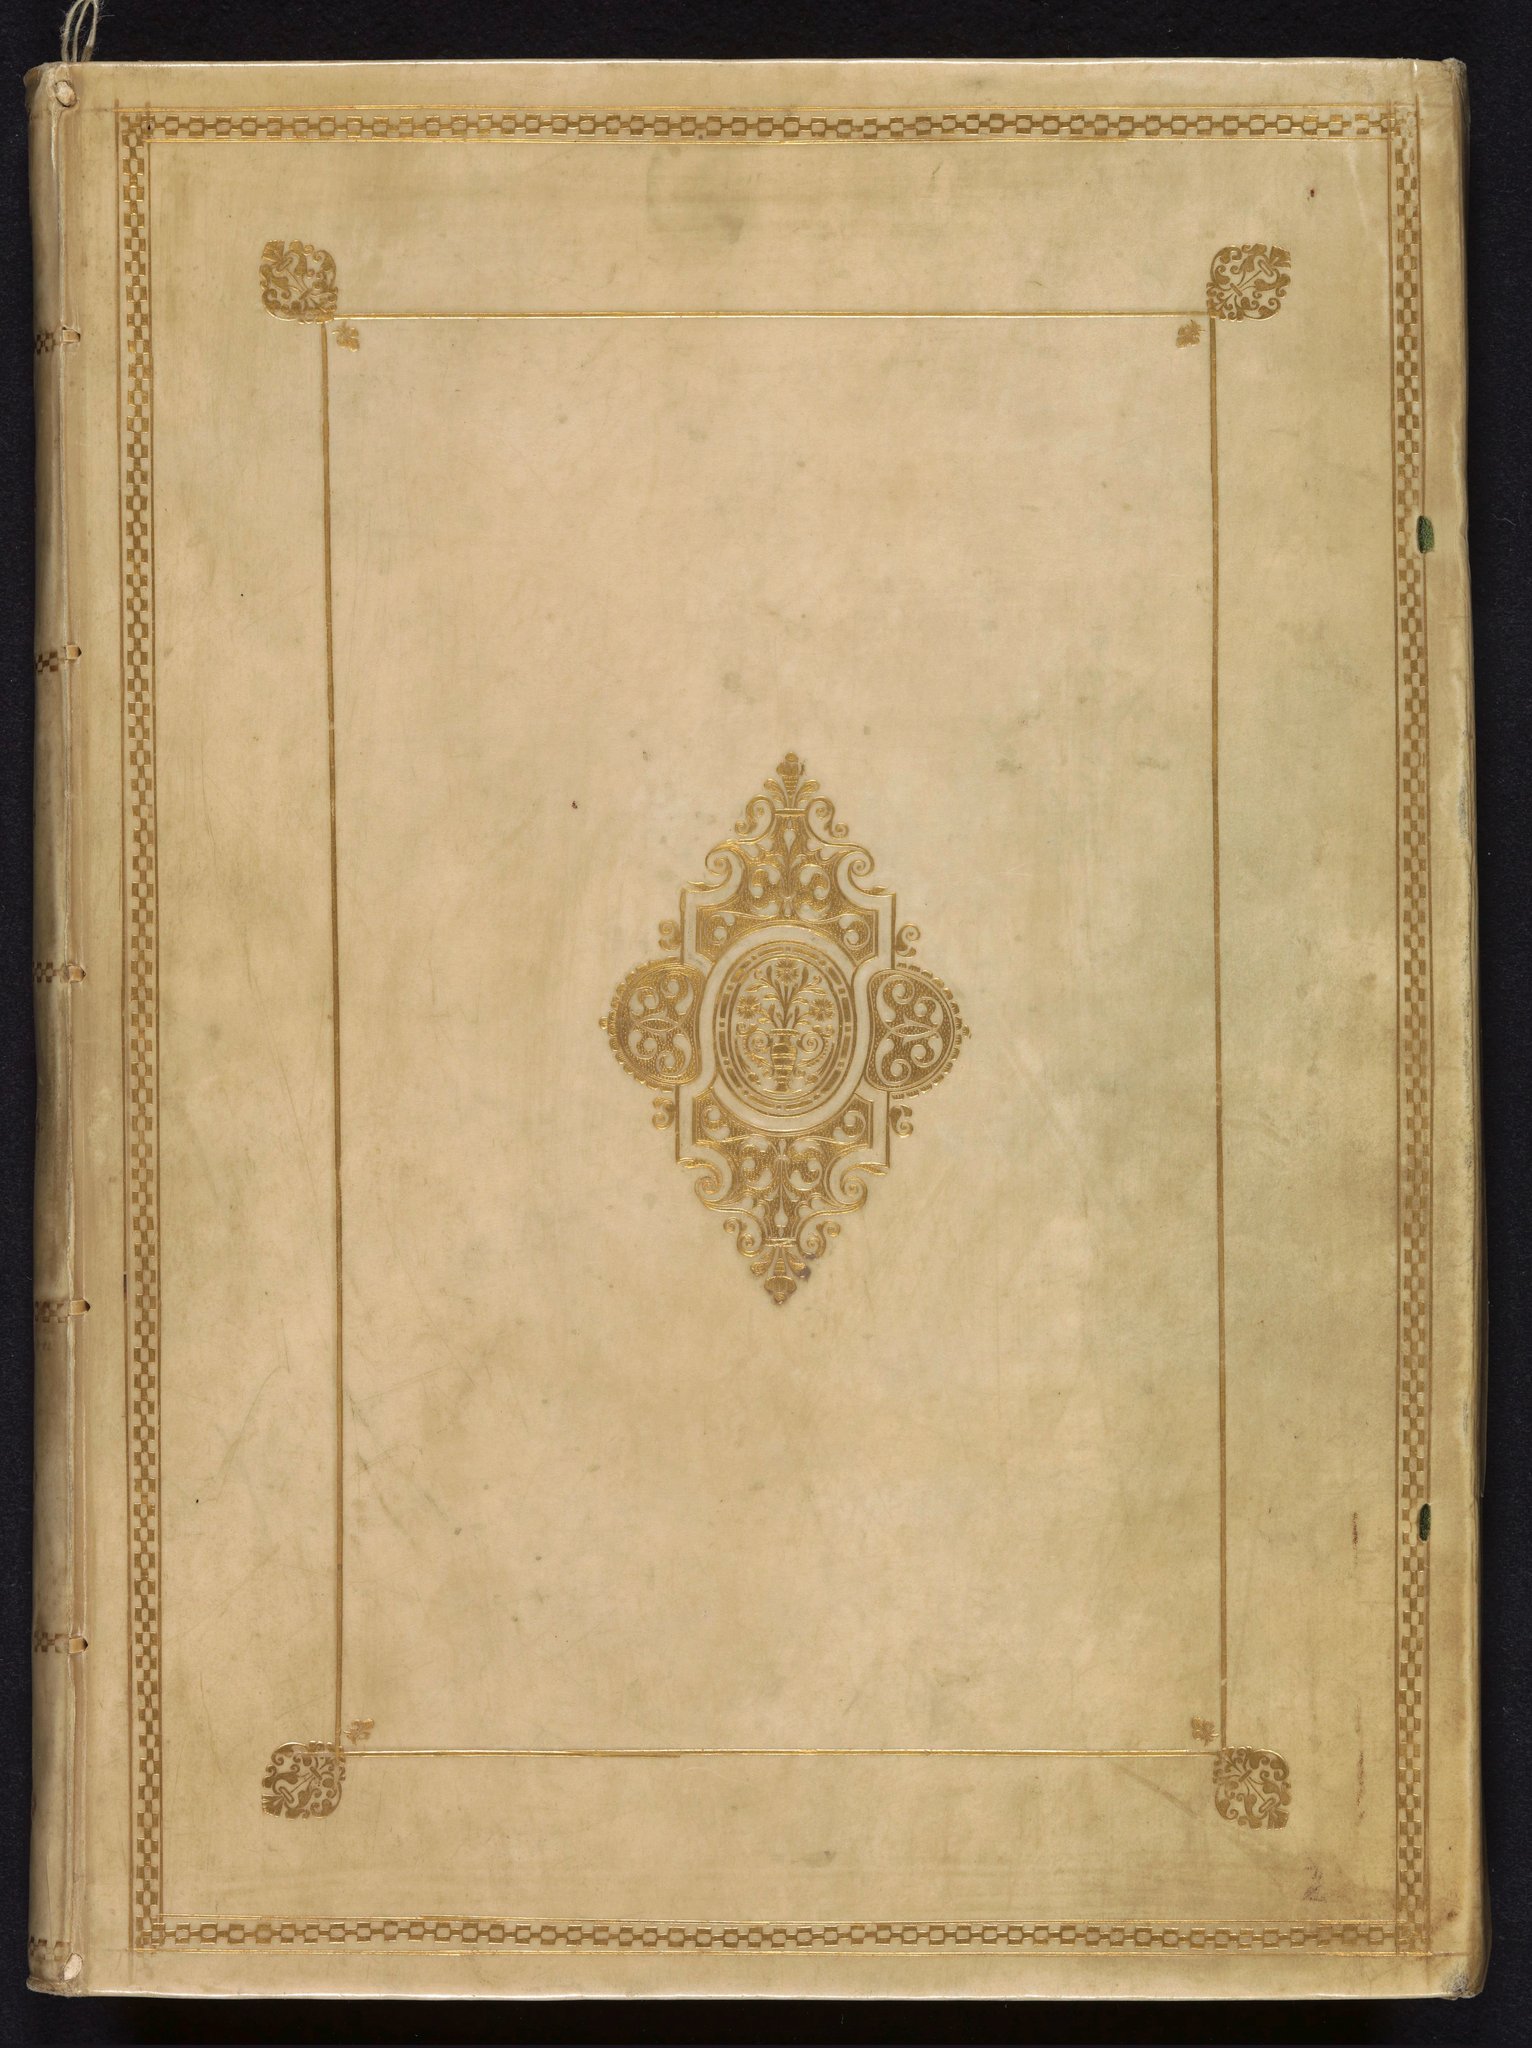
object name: book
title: Holding the Wick in the Right Hand in: Wapenhandelinghe, van roers, musquetten ende spiessen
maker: jacques de gheyn (ii)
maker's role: painter, print maker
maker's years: 1565-1629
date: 1607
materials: paper, parchment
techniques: engraving, hand coloring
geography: the hague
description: The famous book Wapenhandelinghe features 117 engravings of the marksmen, musketeers and lansquenets from the army of Prince Maurice of Orange. All the actions carried out by the soldiers with their weapons are illustrated step by step, from loading to firing and thrusting. This copy is exceptionally beautifully coloured and gilded and was specially made for someone in the prince’s immediate circle.